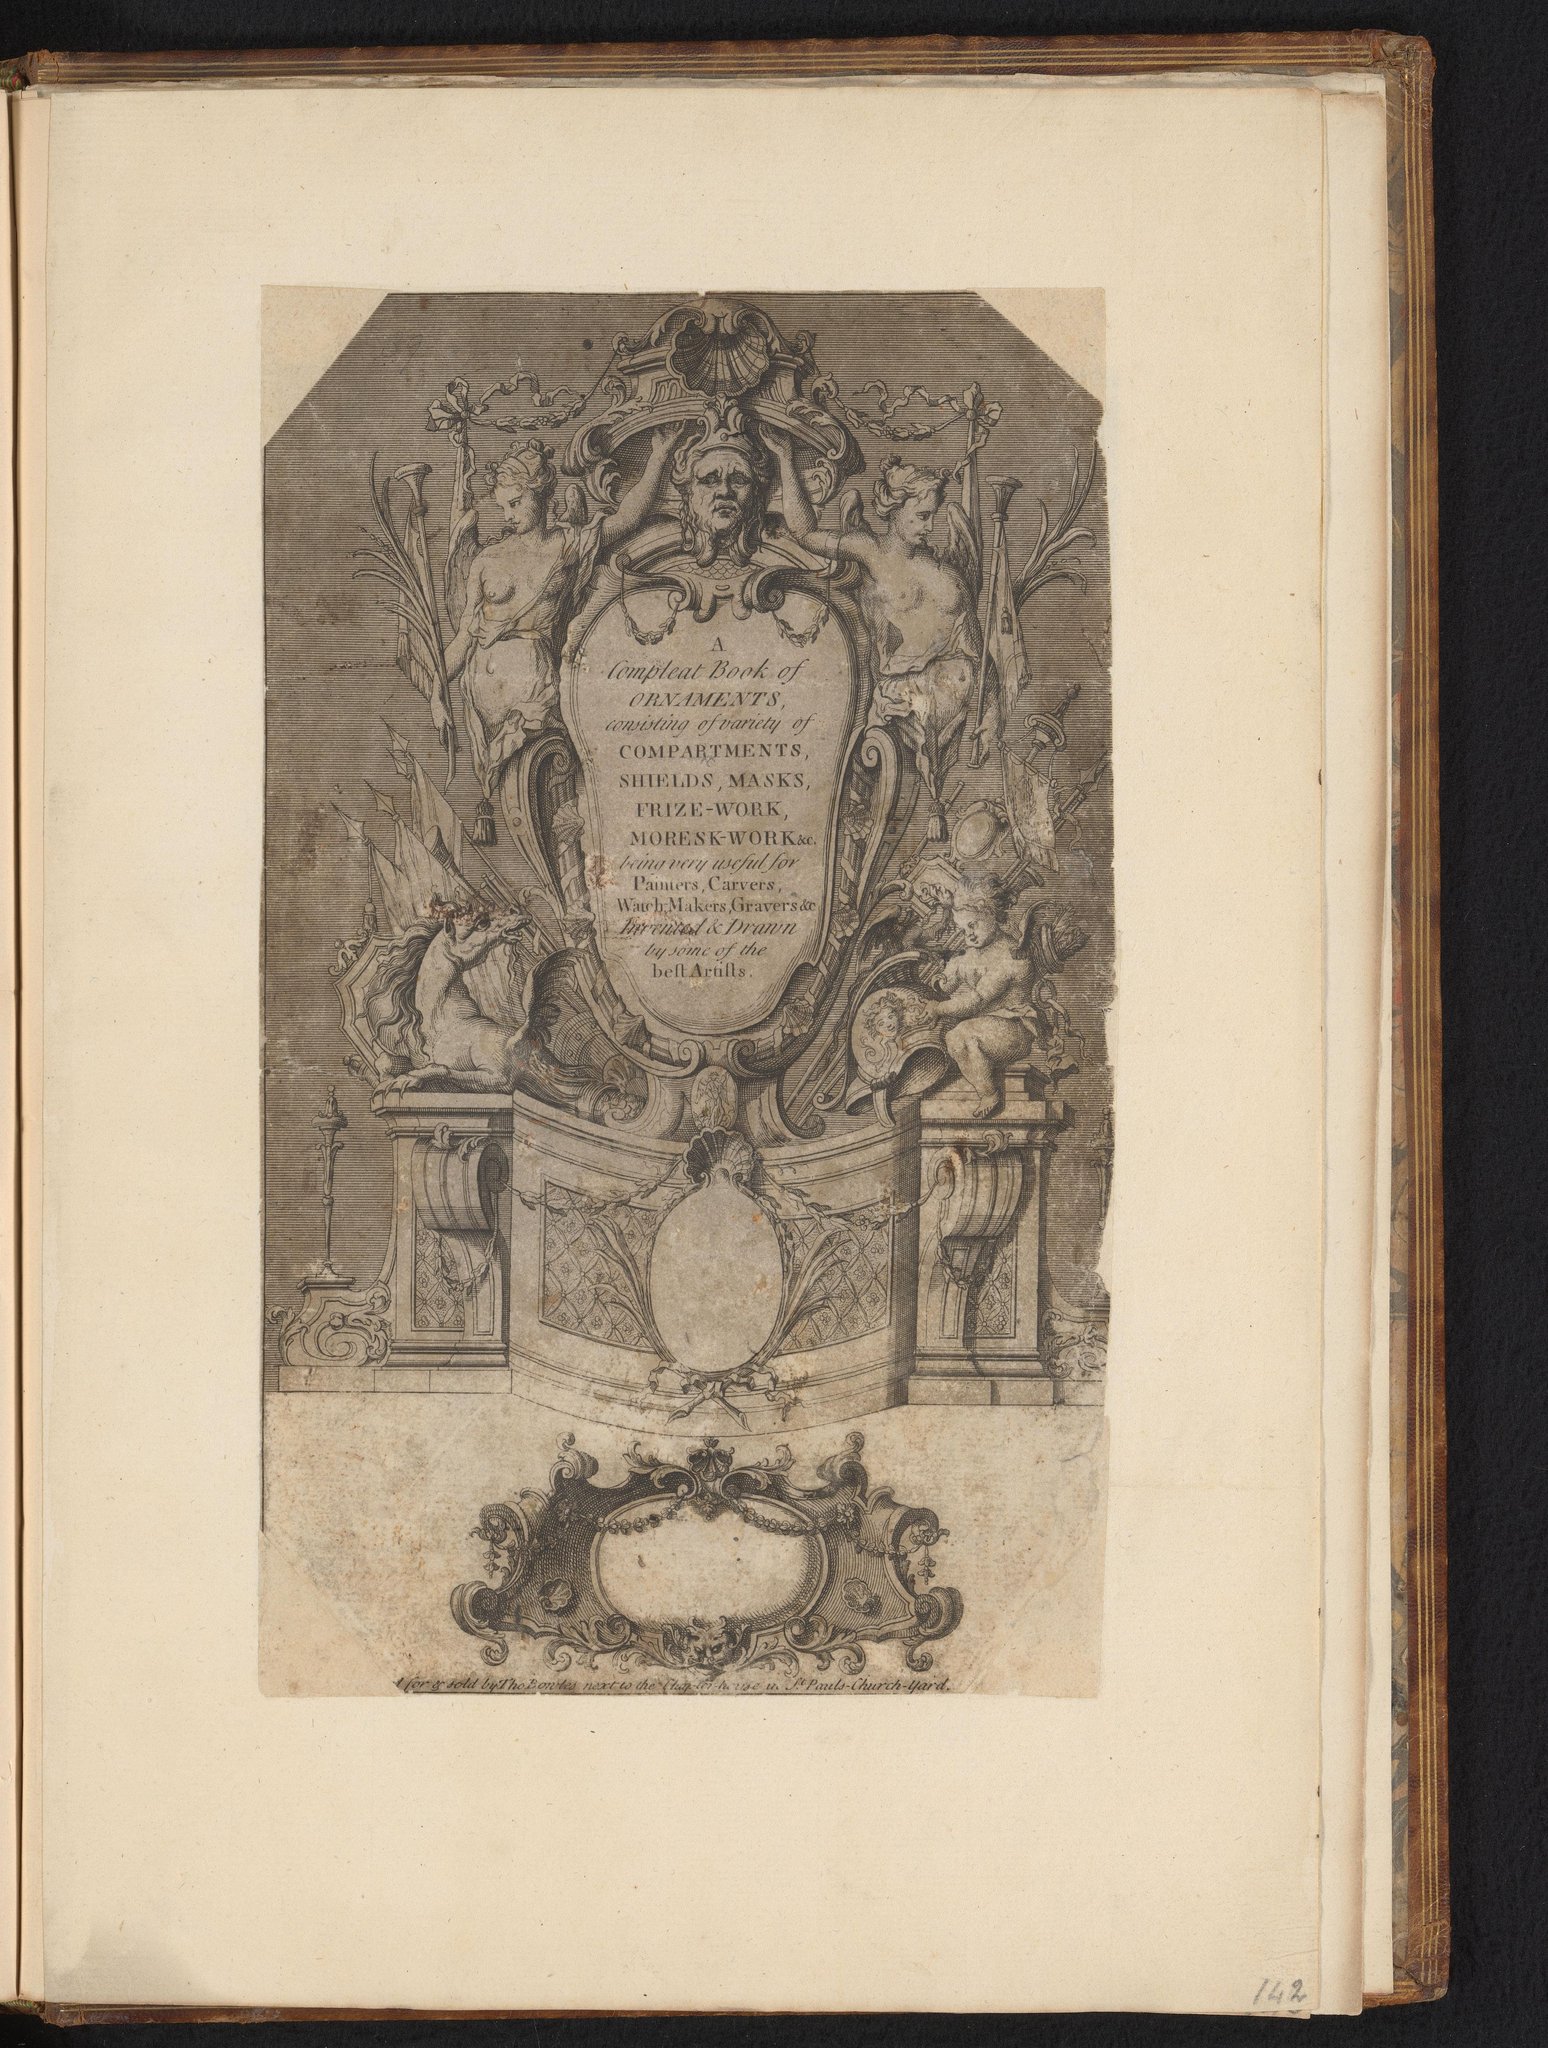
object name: album leaf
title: A Compleat Book of Ornaments [...]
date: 1716-1730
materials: paper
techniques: etching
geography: london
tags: 'tropaion', i.e. decorative ornament ~ weapons, ornament ~ cartouche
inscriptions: collector's mark: Lugt 2228, title: ‘A Compleat Book of/ Ornaments,/ consisting of variety of/ Compartments,/ Shields, Masks,/ Frize-work,/ Moresk-work &c./ being very useful for/ Painters, Carvers,/ Watch Makers, Gravers &c/ Invented & Drawn/ by some of the/ best Artists.’, collector's mark: Lugt 2760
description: Titelprent voor een verder onbekende serie. Het betreft een Londense uitgave met prenten naar ontwerp van Turreau.